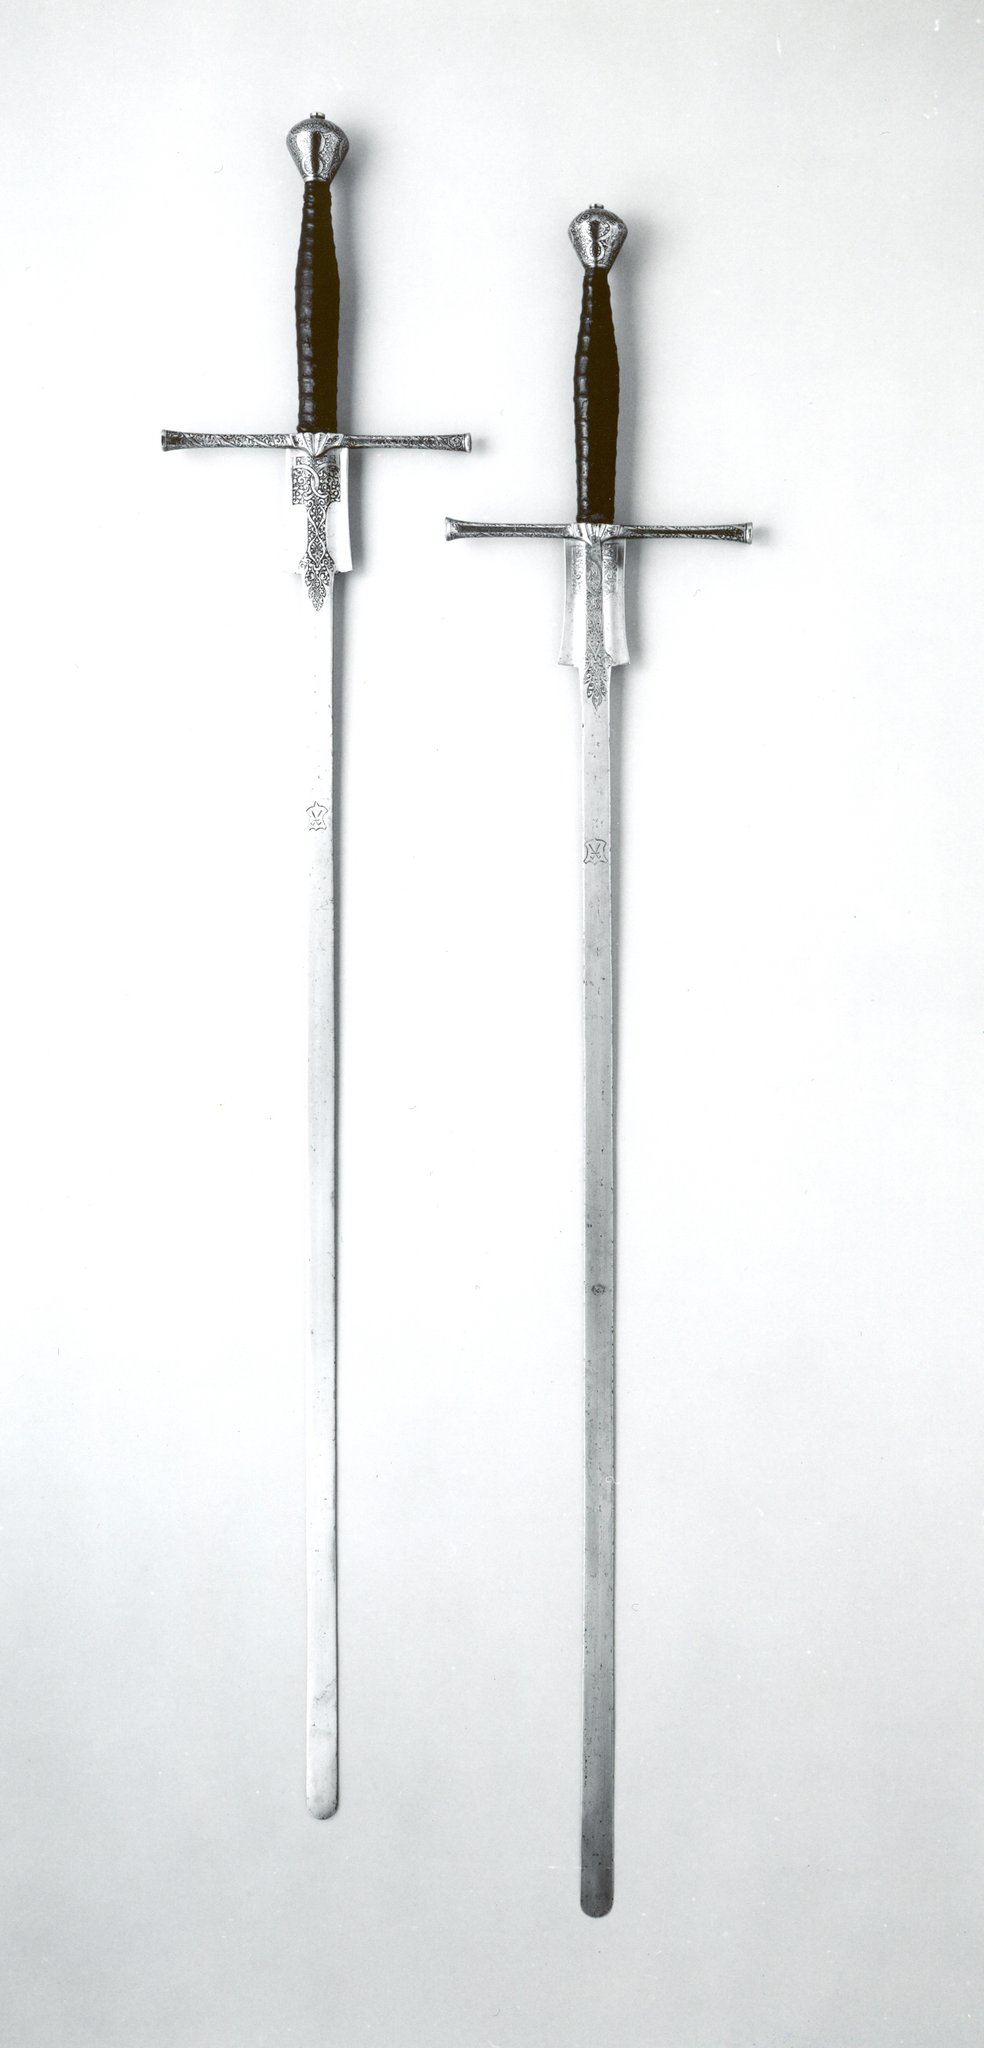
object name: practice sword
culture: german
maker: ulrich diefstetter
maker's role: bladesmith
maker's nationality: german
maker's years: 1536-1589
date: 1575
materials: brass, leather, steel, wood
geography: germany